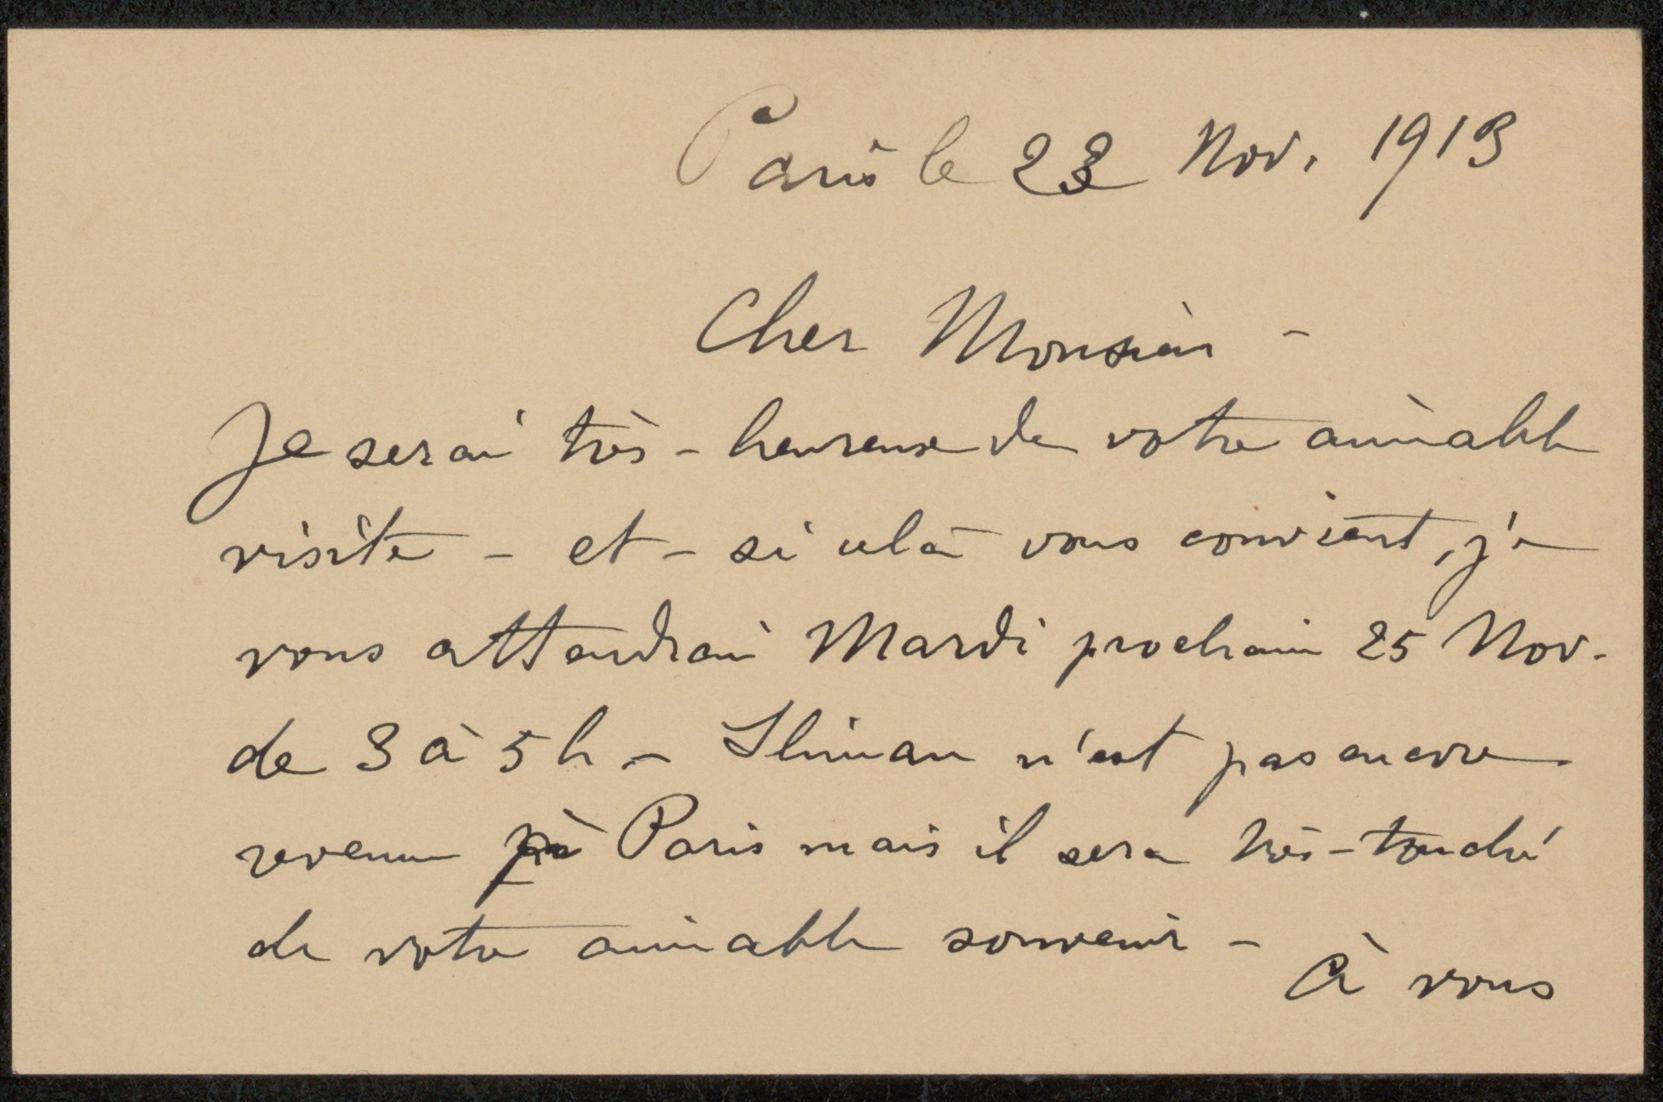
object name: letter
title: Brief aan Philip Zilcken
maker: etienne dinet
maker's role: draughtsman, painter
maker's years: 1861-1929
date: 1913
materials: cardboard, ink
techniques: pen, writing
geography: paris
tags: the hague, philip zilcken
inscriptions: collector's mark: ‘RPK’